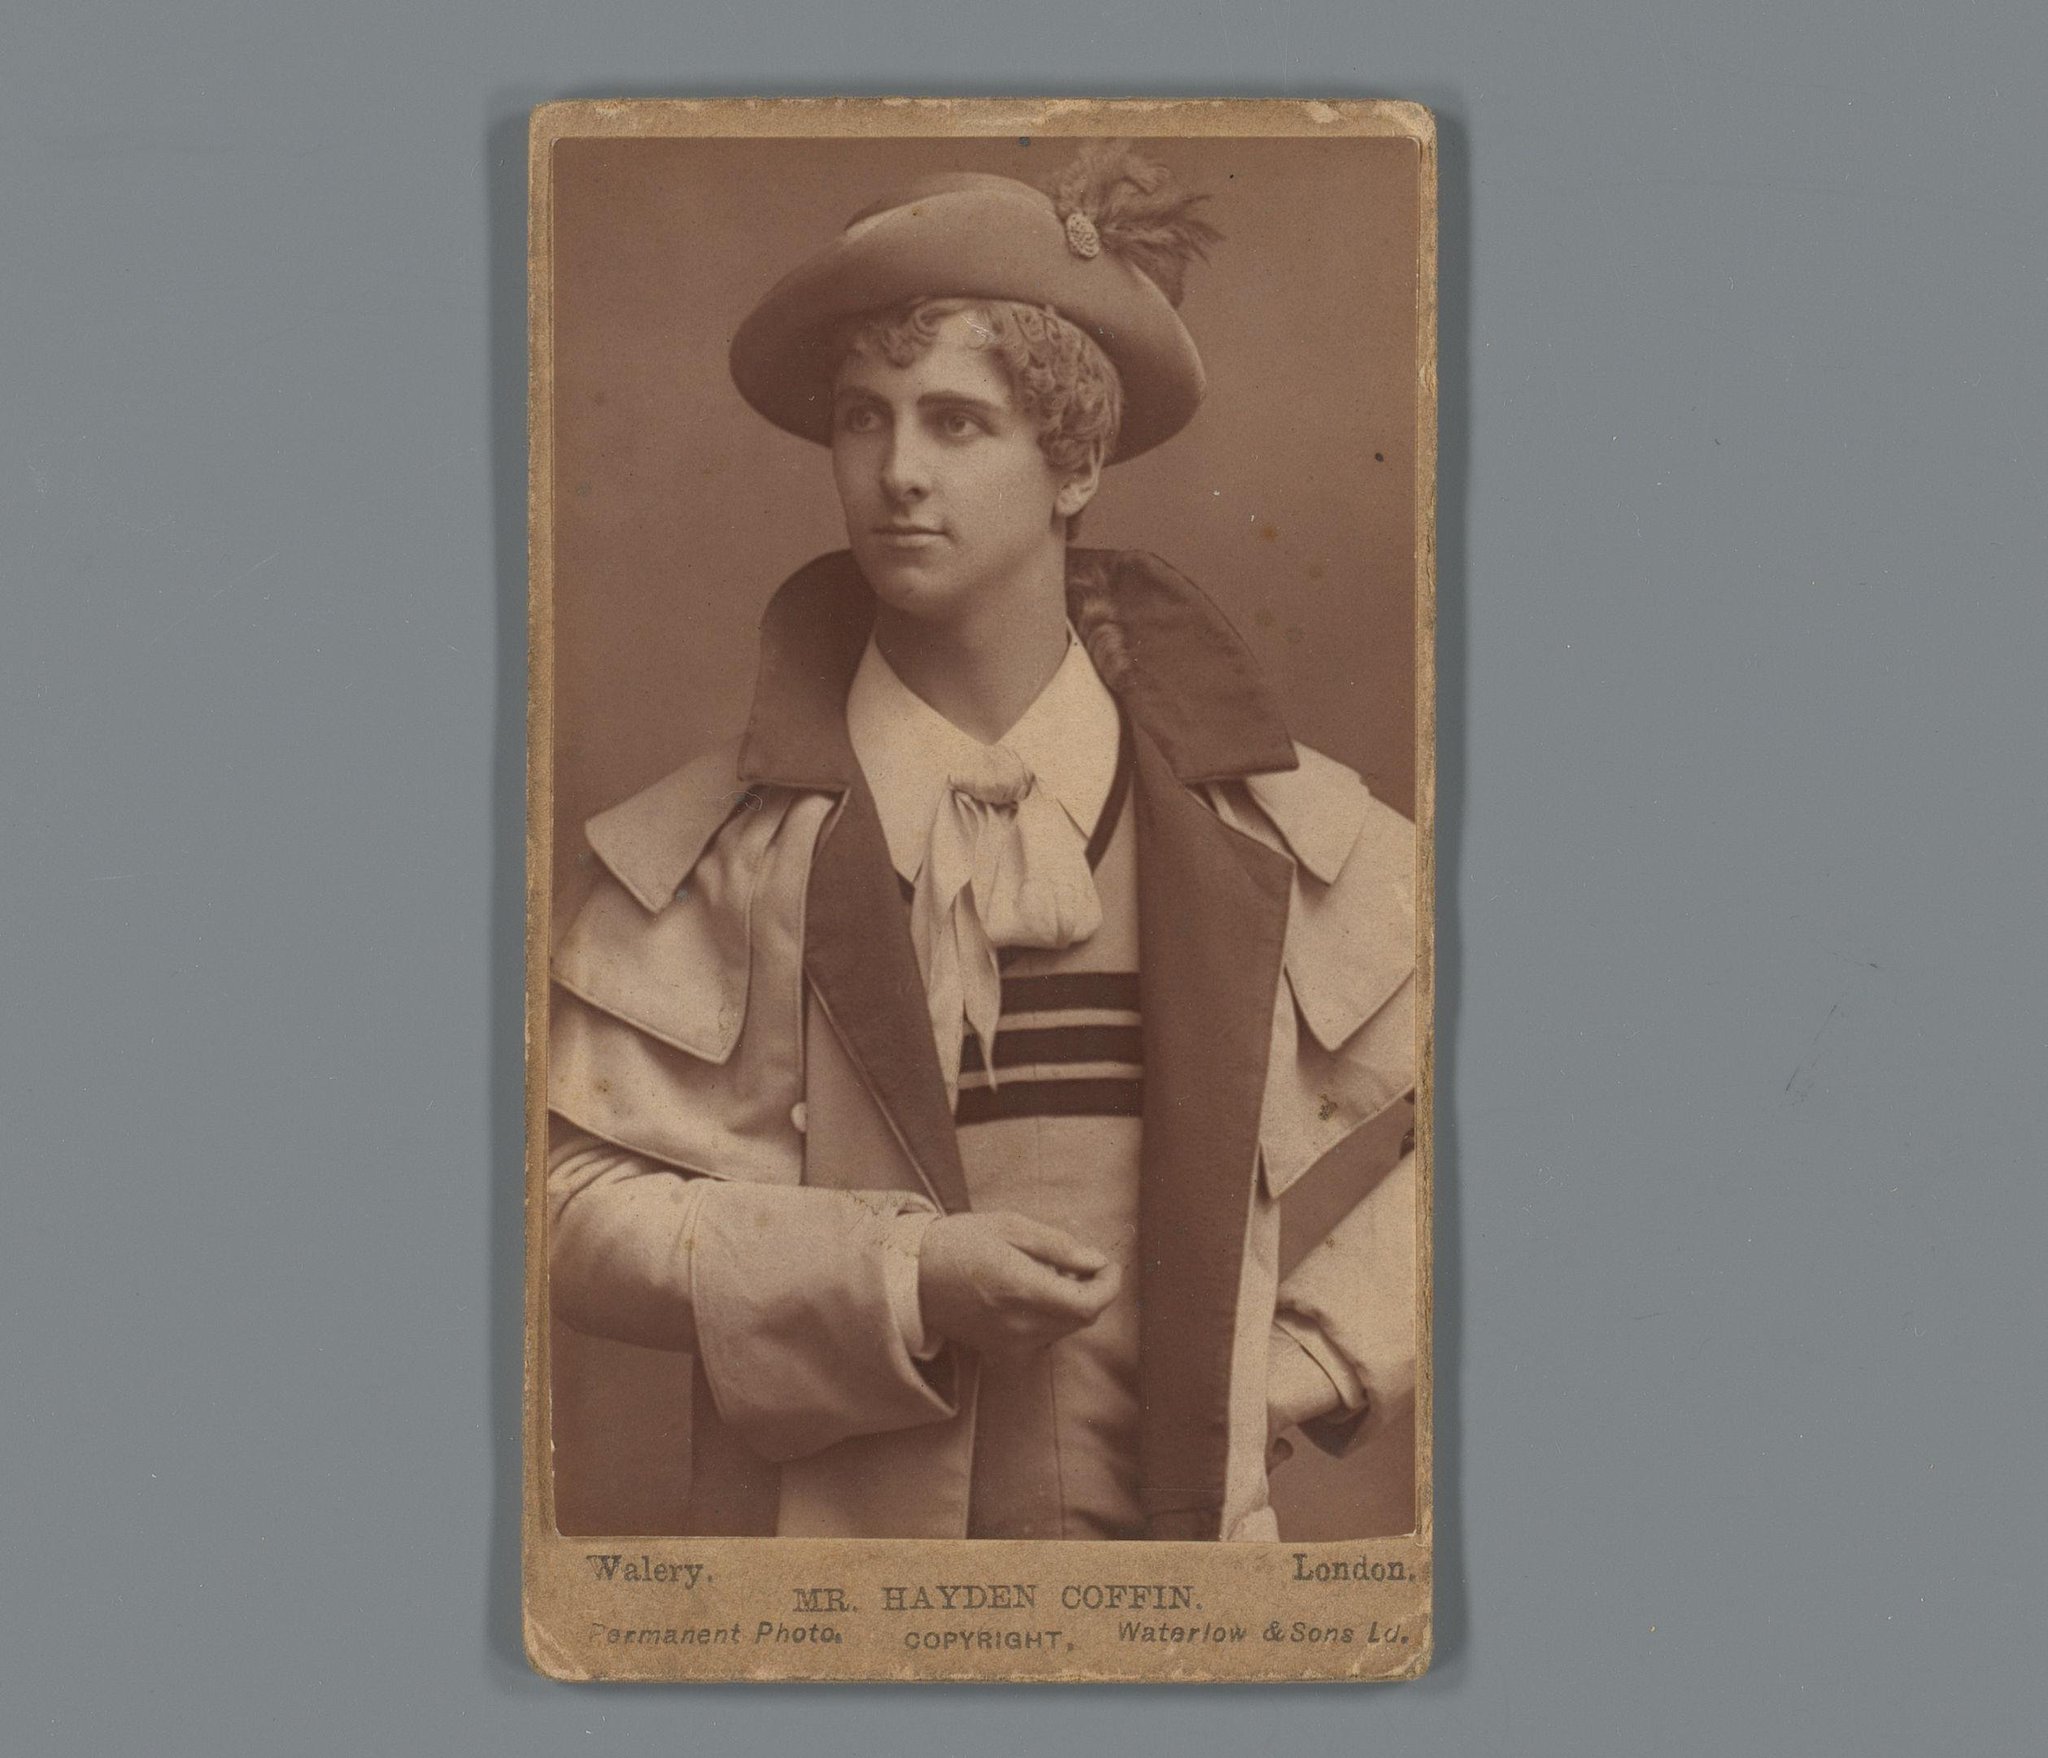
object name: carte de visite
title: Mr. Hayden Coffin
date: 1880-1940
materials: cardboard, photographic support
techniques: woodburytype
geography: london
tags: london, advertising, historical persons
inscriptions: inscription: ‘Walery/ London./ Permanent Photo./ COPYRIGHT,/ Waterlow & Sons, L(...).’